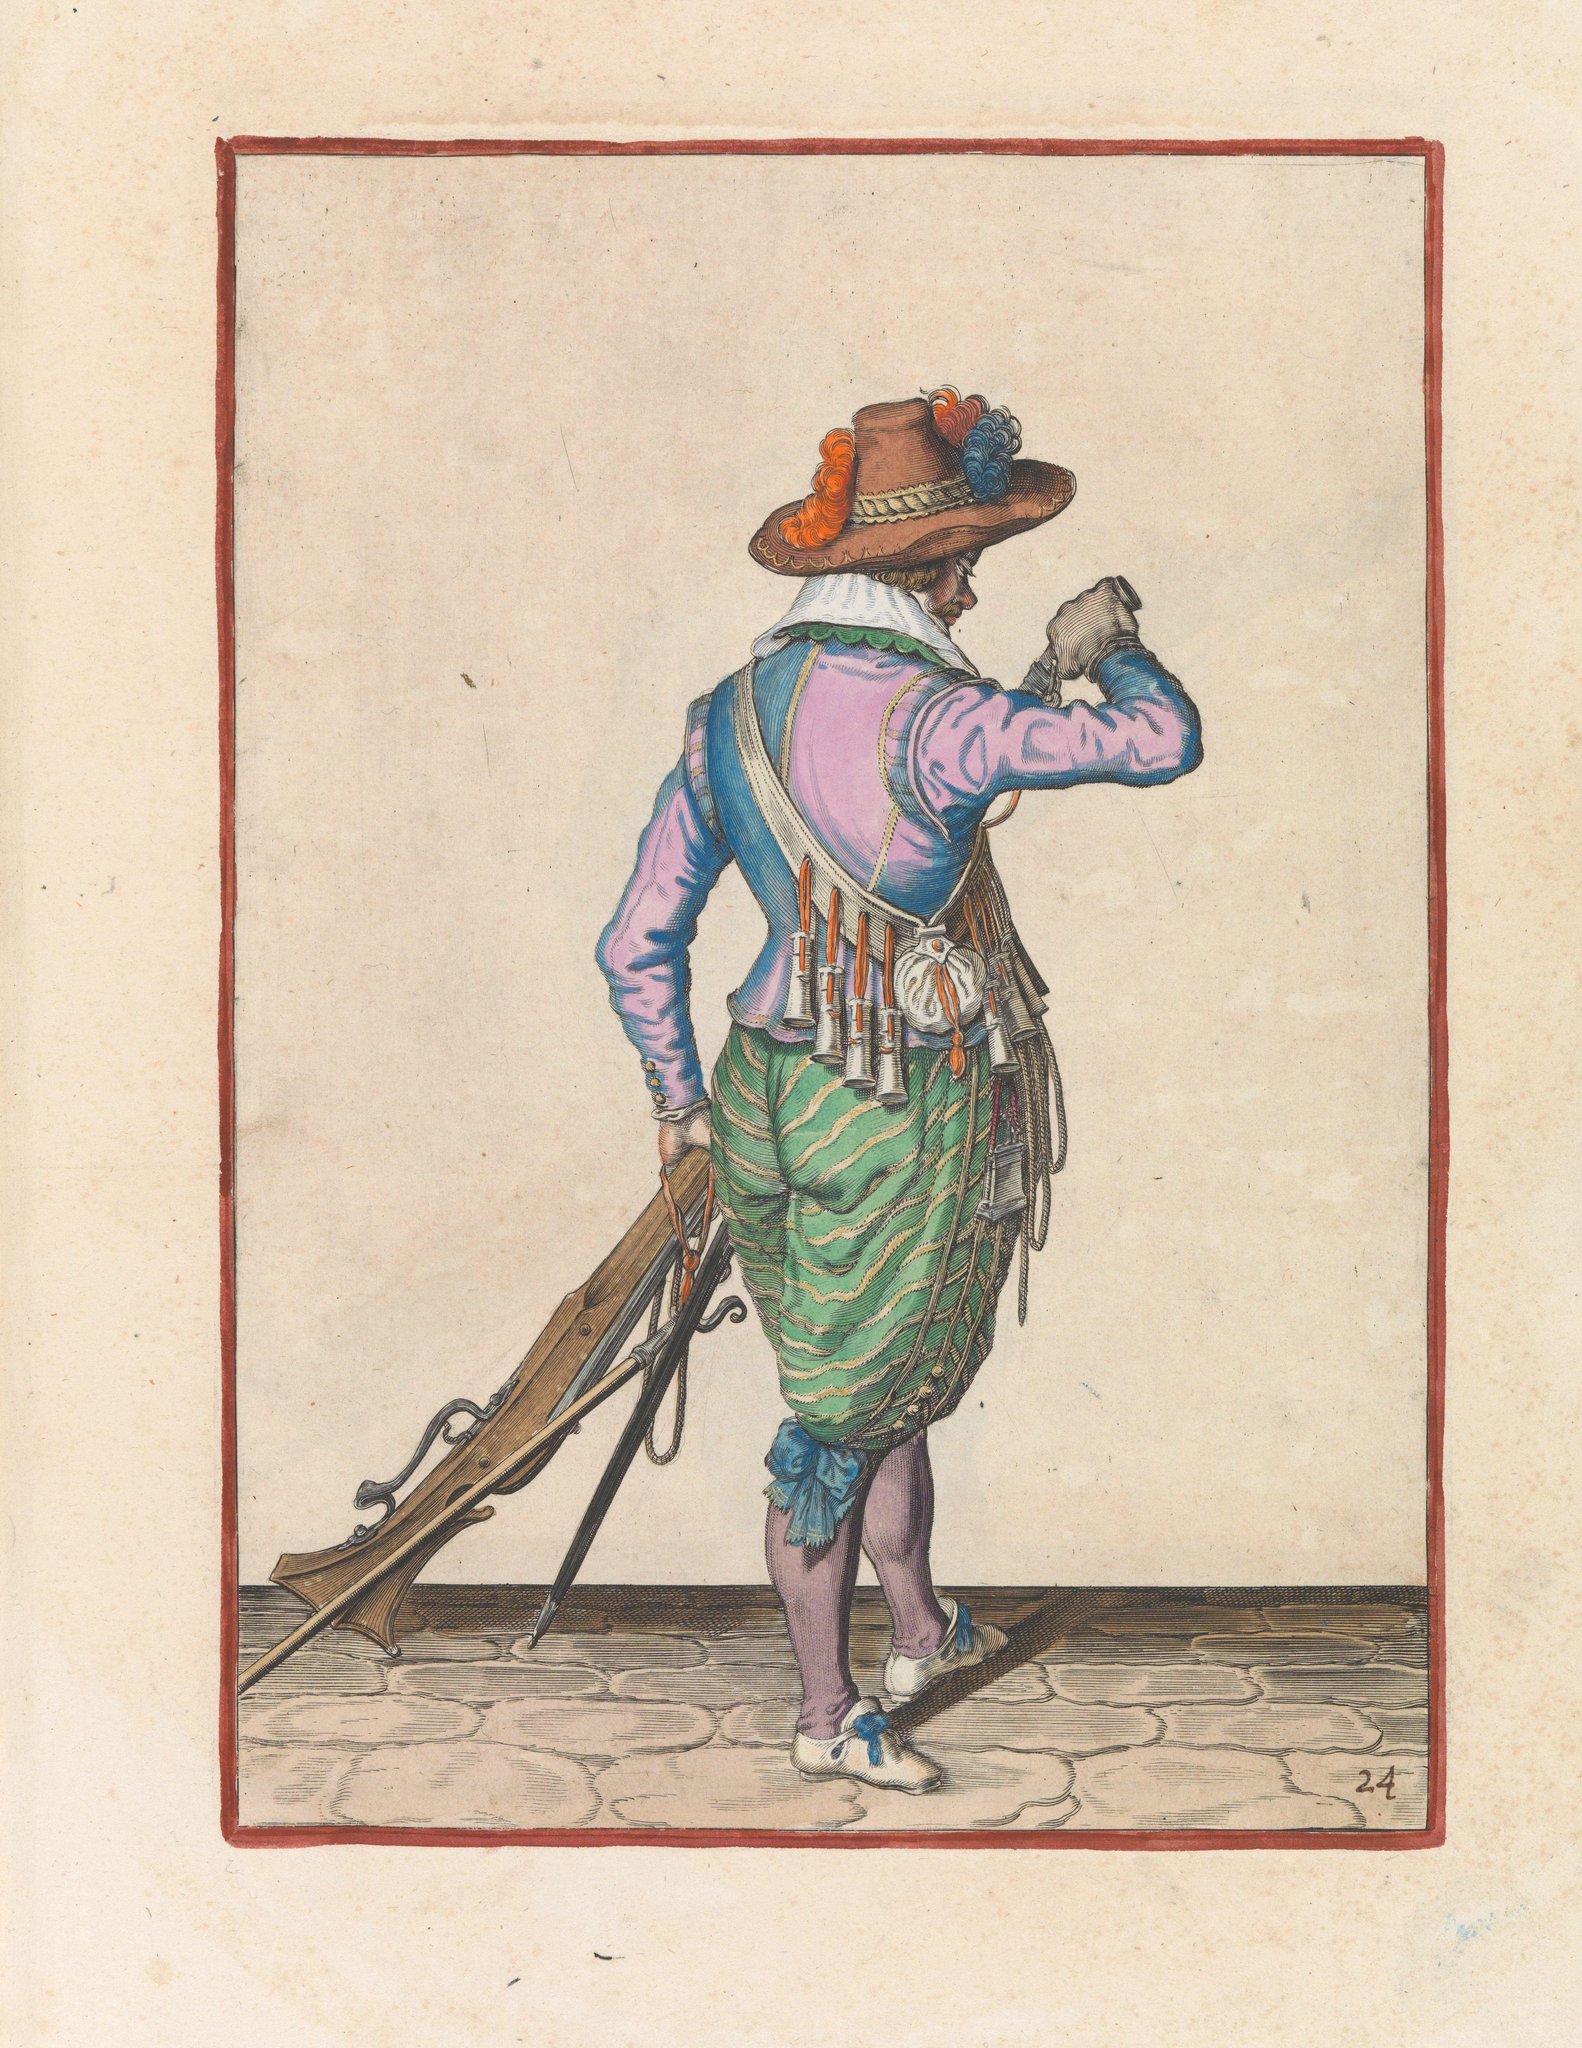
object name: print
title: Corte onderrechtinghe op de figuerliicke afbeeldinghe, soo veel aengaet het recht ghebruyck vant Musquet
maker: jacques de gheyn (ii)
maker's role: painter, print maker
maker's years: 1565-1629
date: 1597-1607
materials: paper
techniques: engraving, hand coloring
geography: the hague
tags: handling of weapons ~ military training, firearms: rifle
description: Een soldaat, ten voeten uit, naar rechts, op de rug gezien, die met zijn linkerhand bij zijn linkerdijbeen een musket (een bepaald type vuurwapen) vasthoudt. In zijn linkerhand behalve het musket ook een lont; aan zijn linkerpols een furket (musketvork). Met zijn rechterhand giet hij kruit uit een kruitmaatje in de loop, die schuin omhoog wijst. Deze prent is onderdeel van de reeks van 43 met de hand genummerde prenten van musketiers in de Wapenhandelinghe.